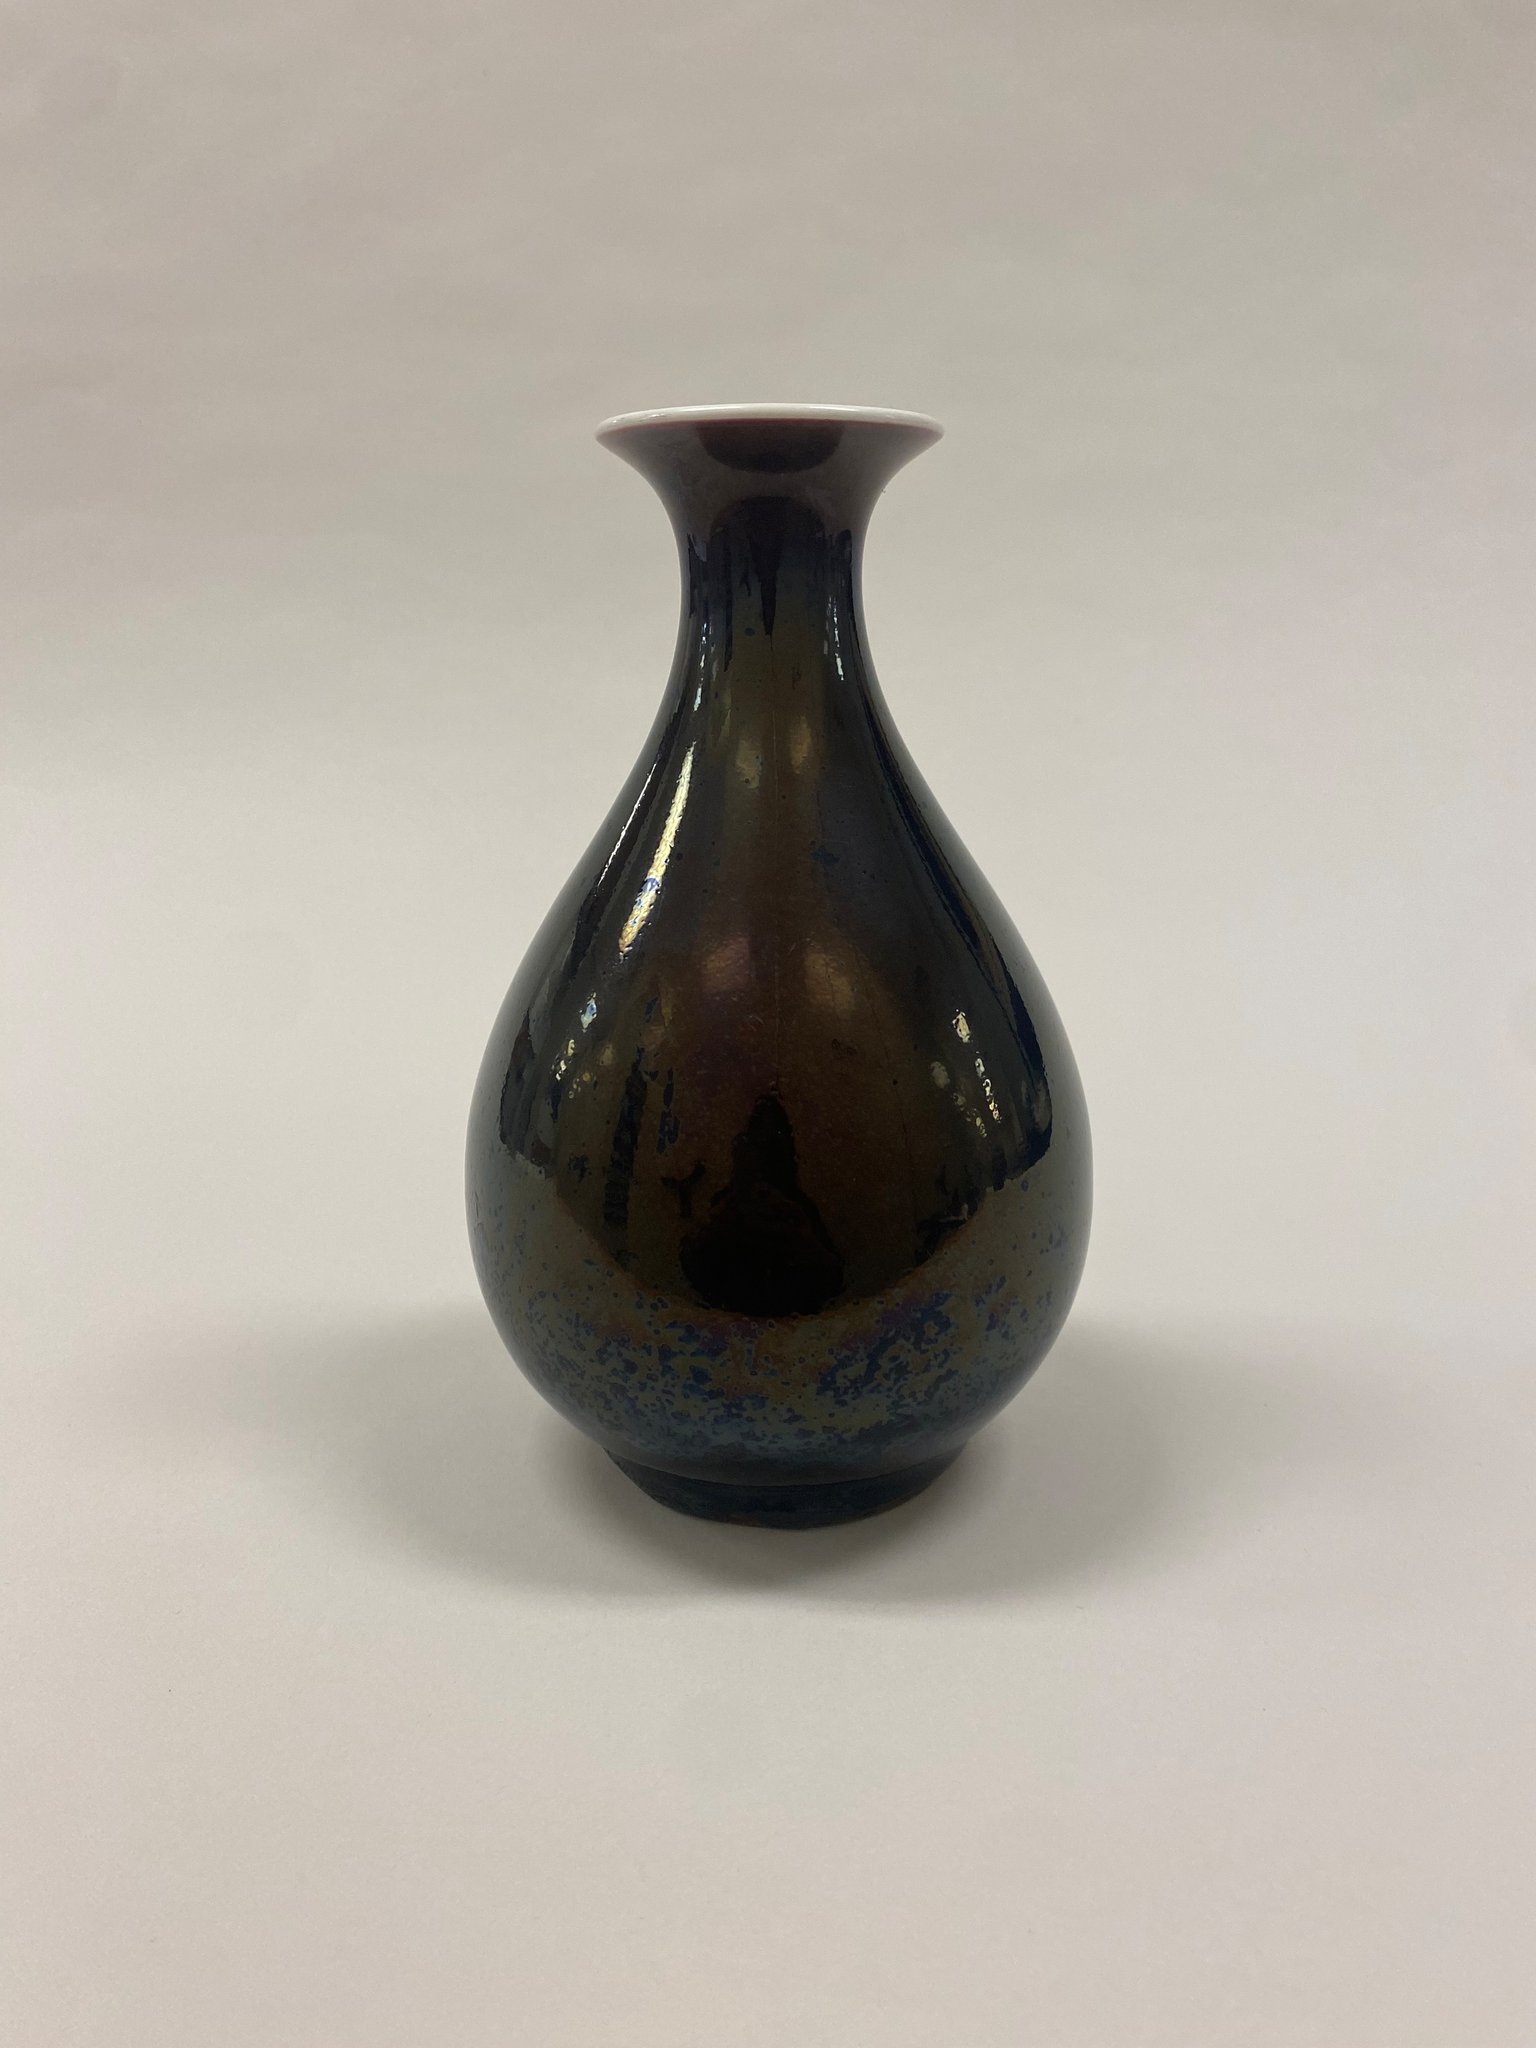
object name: vase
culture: chinese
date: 1701-1800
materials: glaze, porcelain